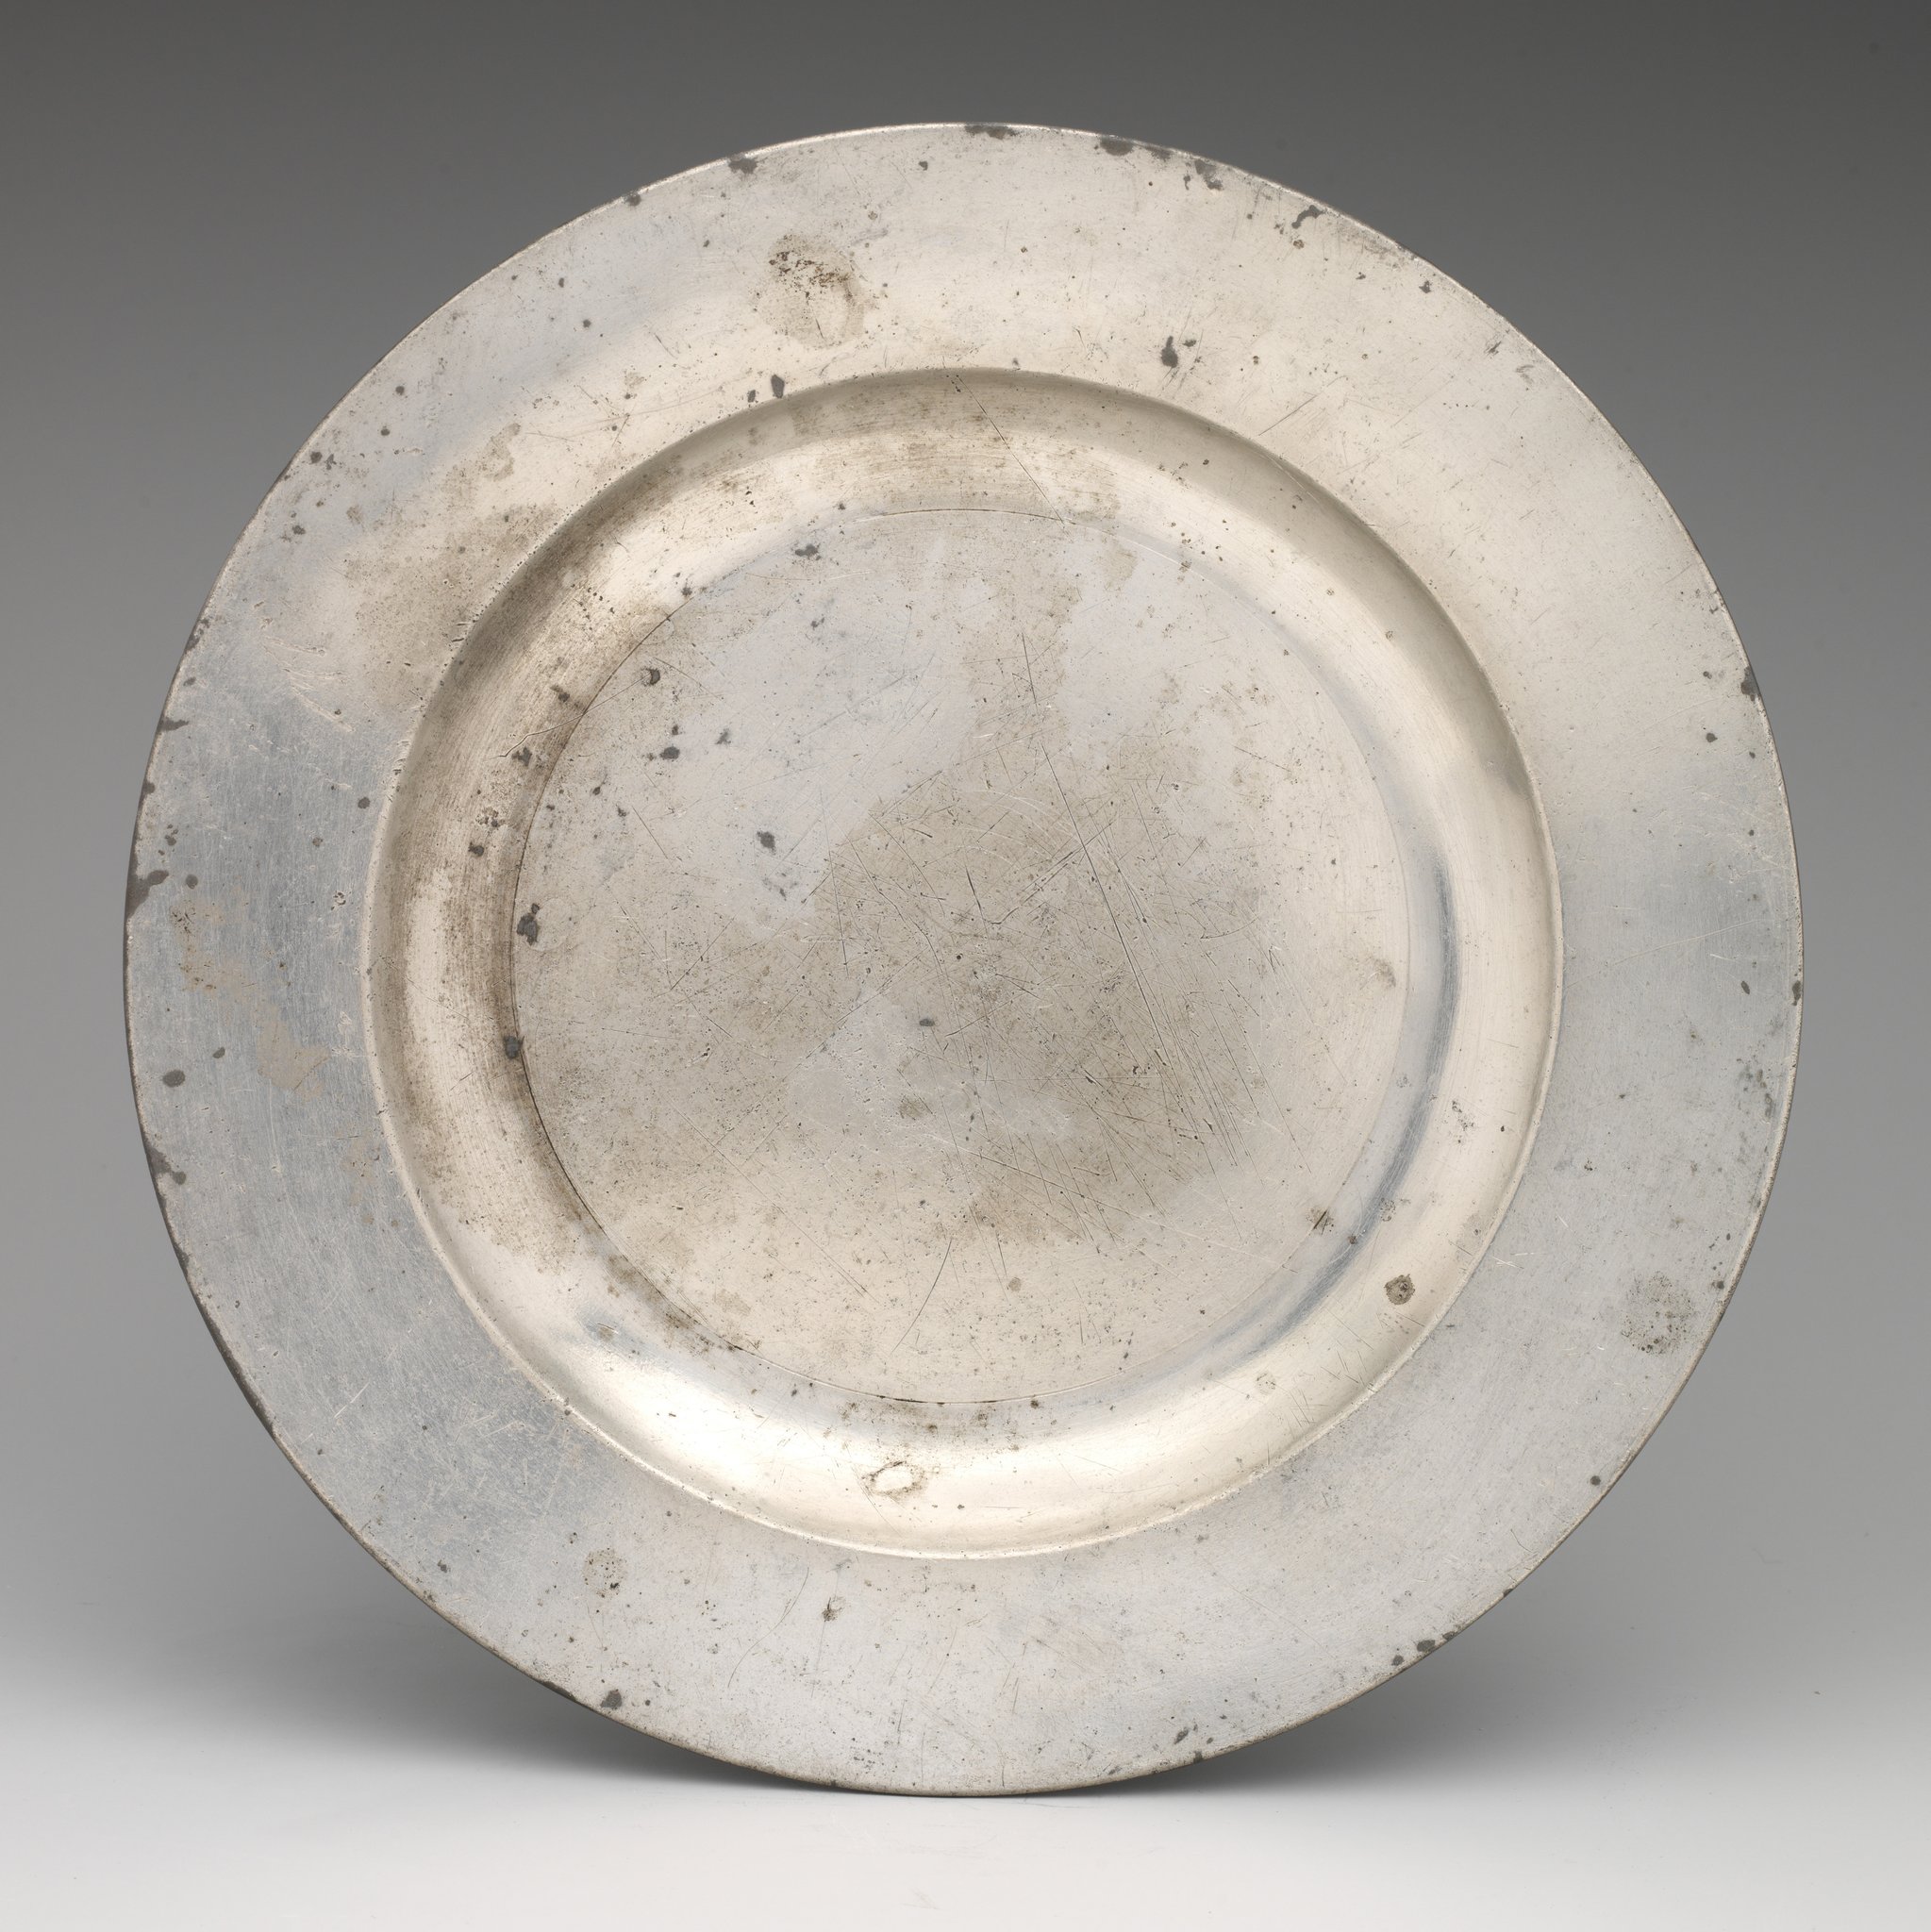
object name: plate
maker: thomas giffin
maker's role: maker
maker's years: 1760-1777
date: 1751-1775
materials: pewter